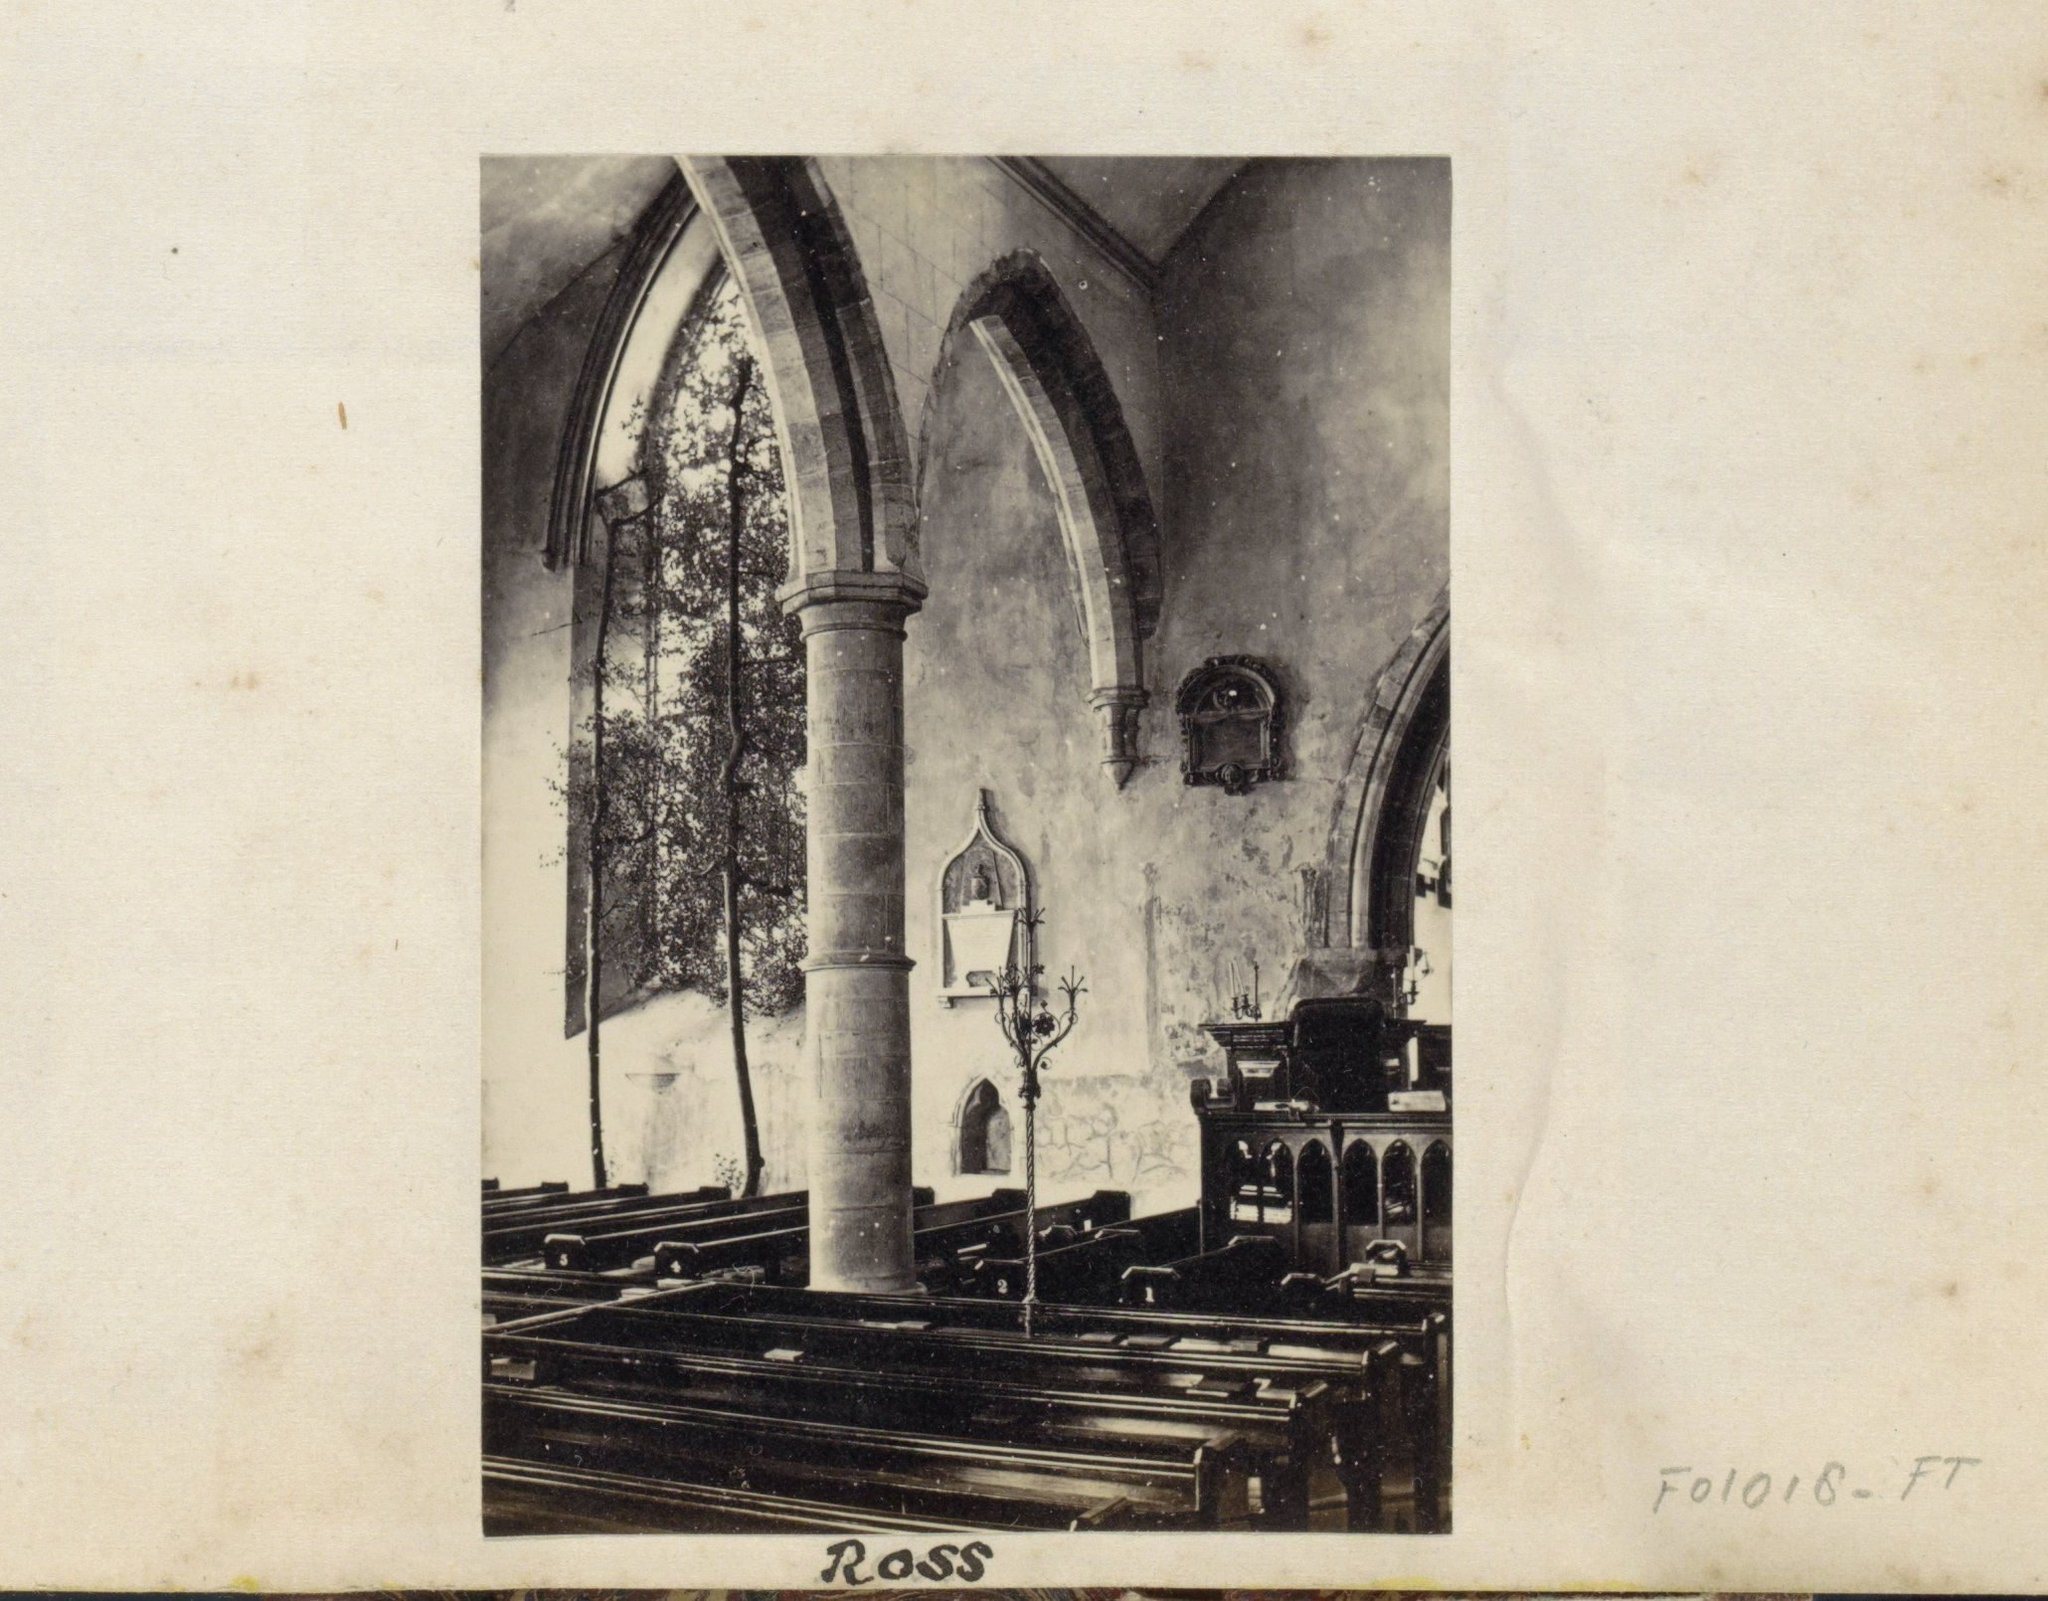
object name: photograph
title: Interieur van de kerk van Ross-on-Wye met links uitlopers van iepen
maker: Anonymous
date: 1860-1870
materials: paper, photographic support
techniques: albumen print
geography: ross-on-wye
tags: trees: elm, column, pillar ~ architecture, arch, archivolt ~ architecture, interior of church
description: Onderdeel van Engels familiealbum met foto's van personen, reizen, cricket en kunstwerken.